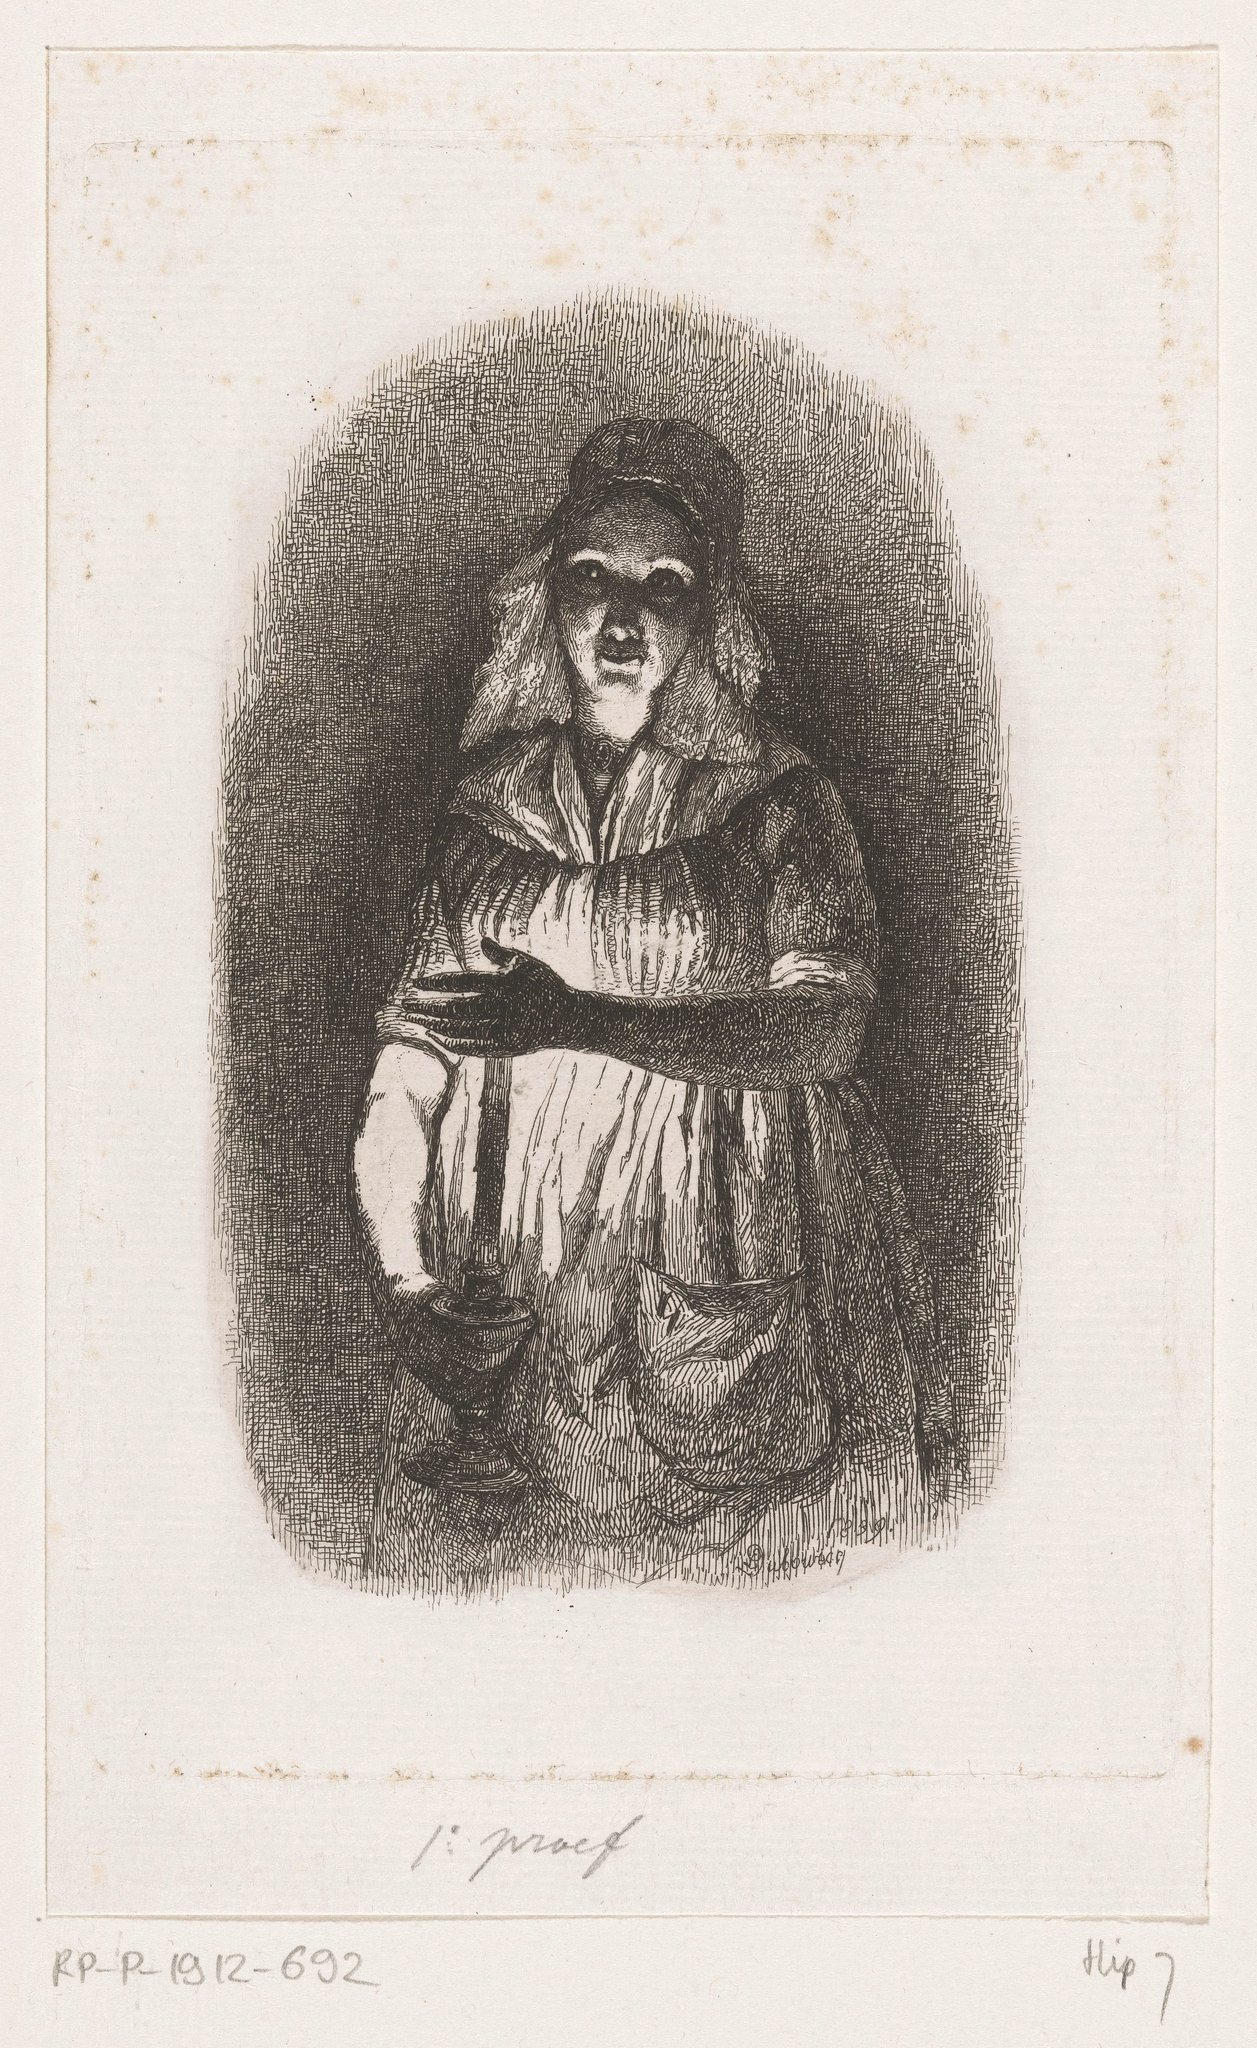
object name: print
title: Vijf etsproeven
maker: pierre louis dubourcq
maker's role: draughtsman, painter, print maker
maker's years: 1815-1873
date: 1839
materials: paper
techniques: etching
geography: netherlands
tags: maid ~ house personnel, chandelier, candelabrum (+ kindling a light; lit, burning light, lamp, candle)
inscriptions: collector's mark: Lugt 2228